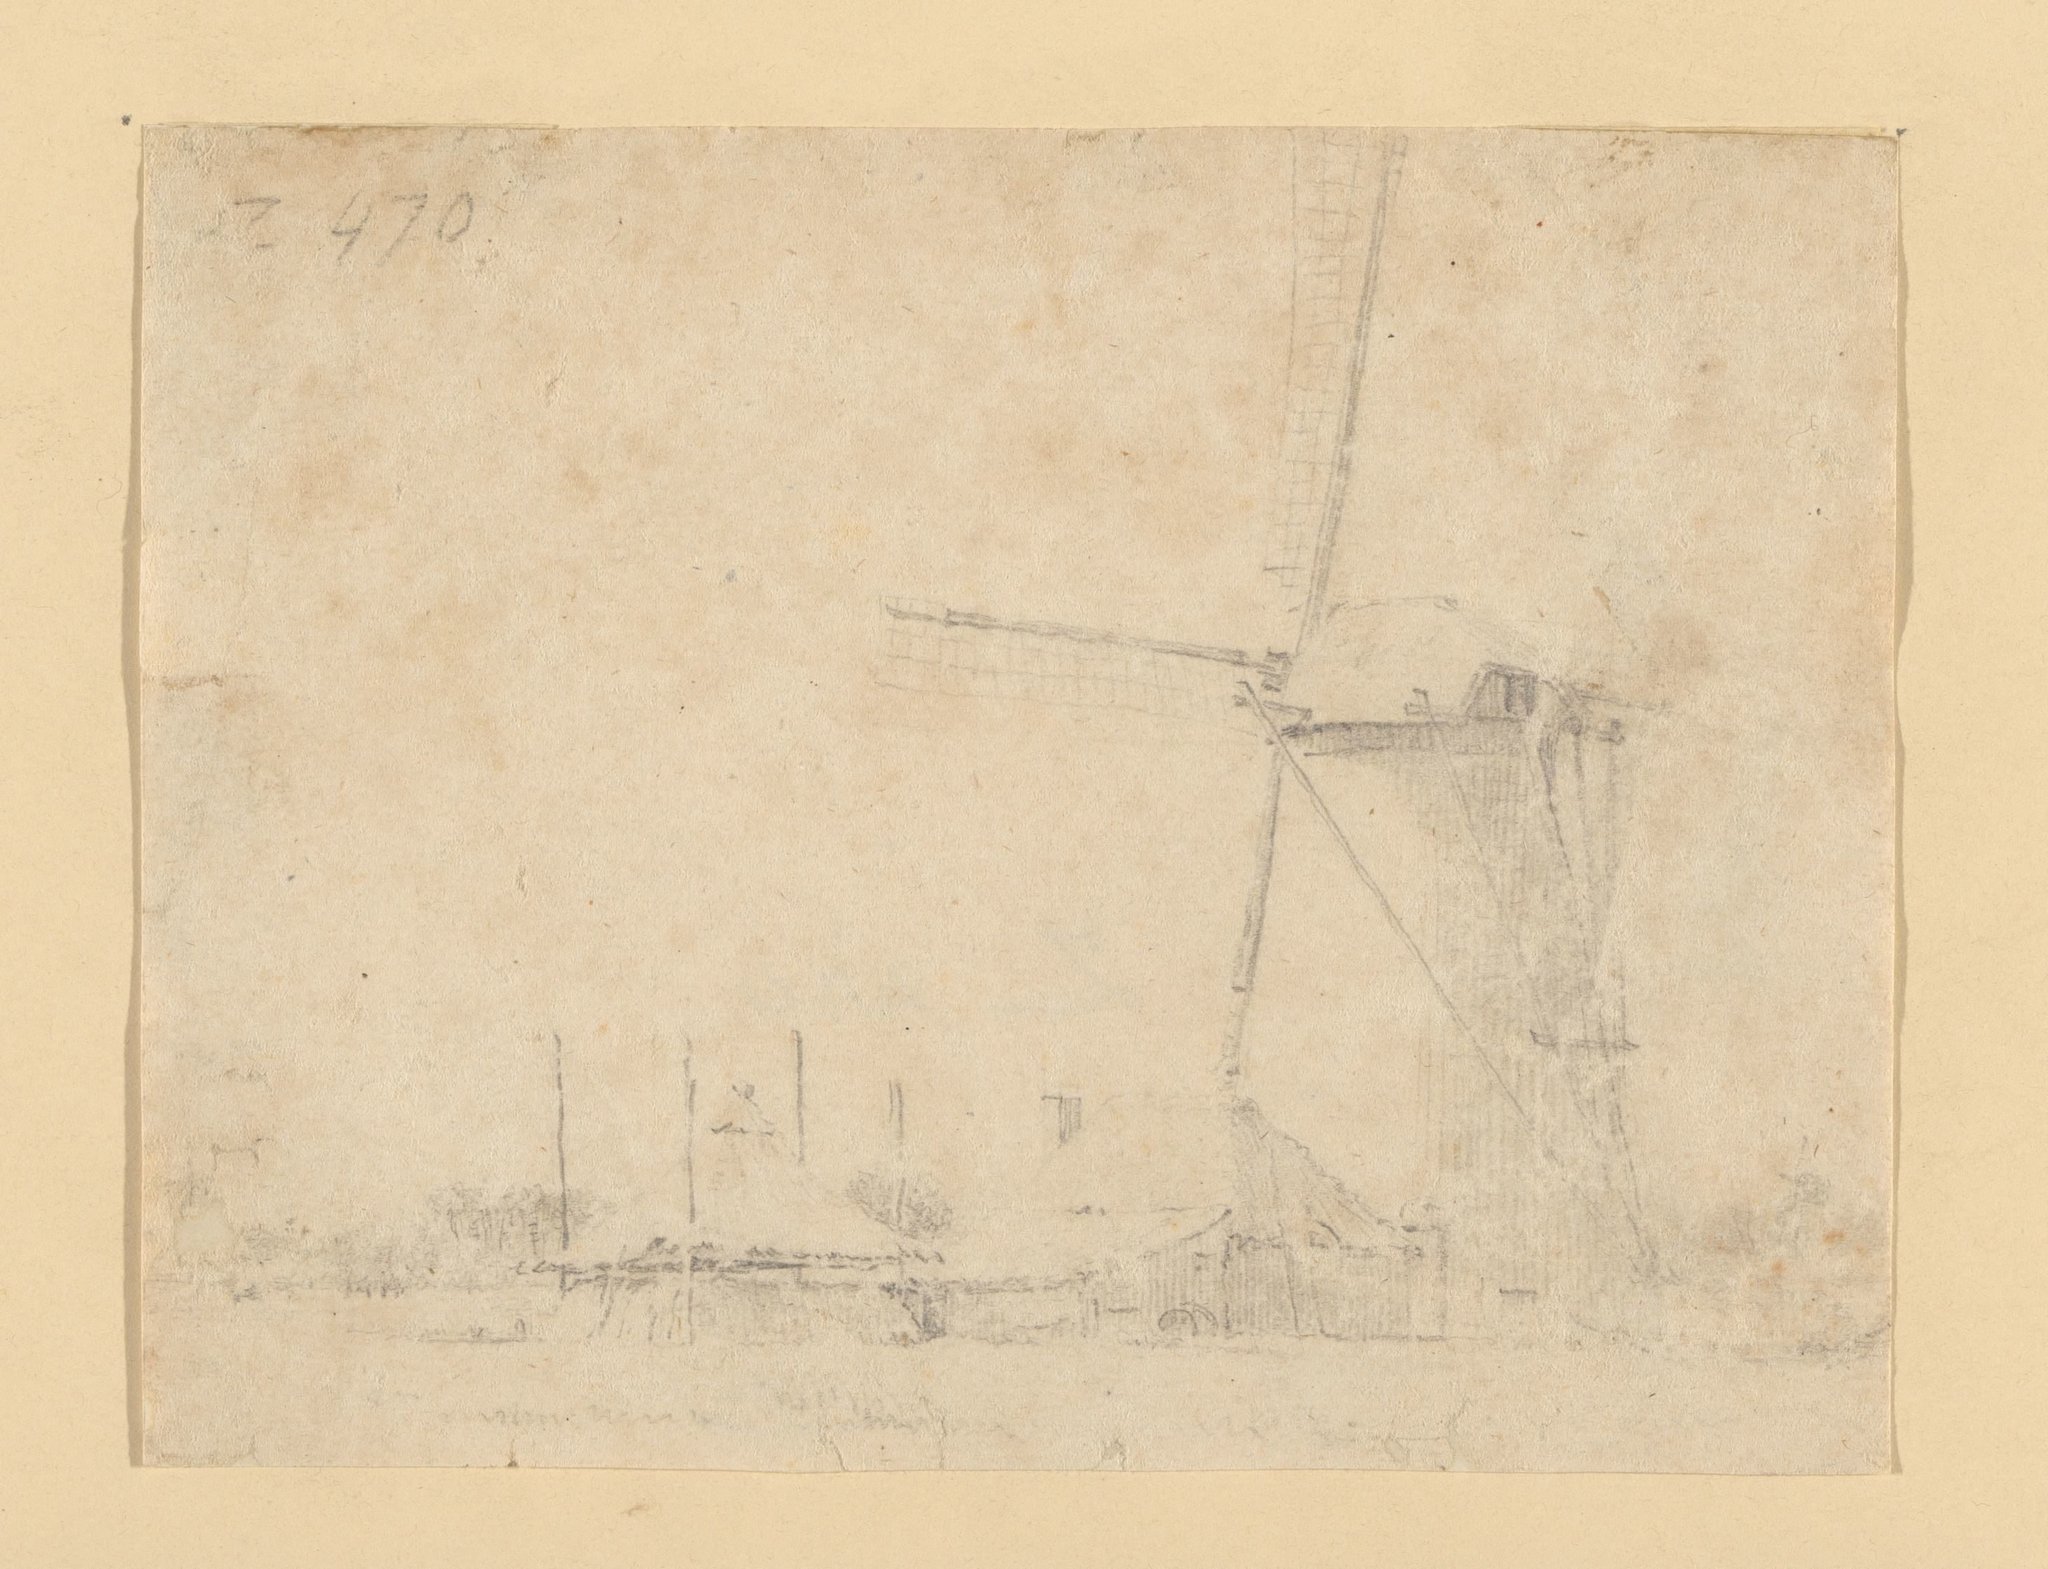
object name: drawing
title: Gezicht op een boerderij met windmolen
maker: Anonymous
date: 1700-1800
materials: paper, pencil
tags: windmill